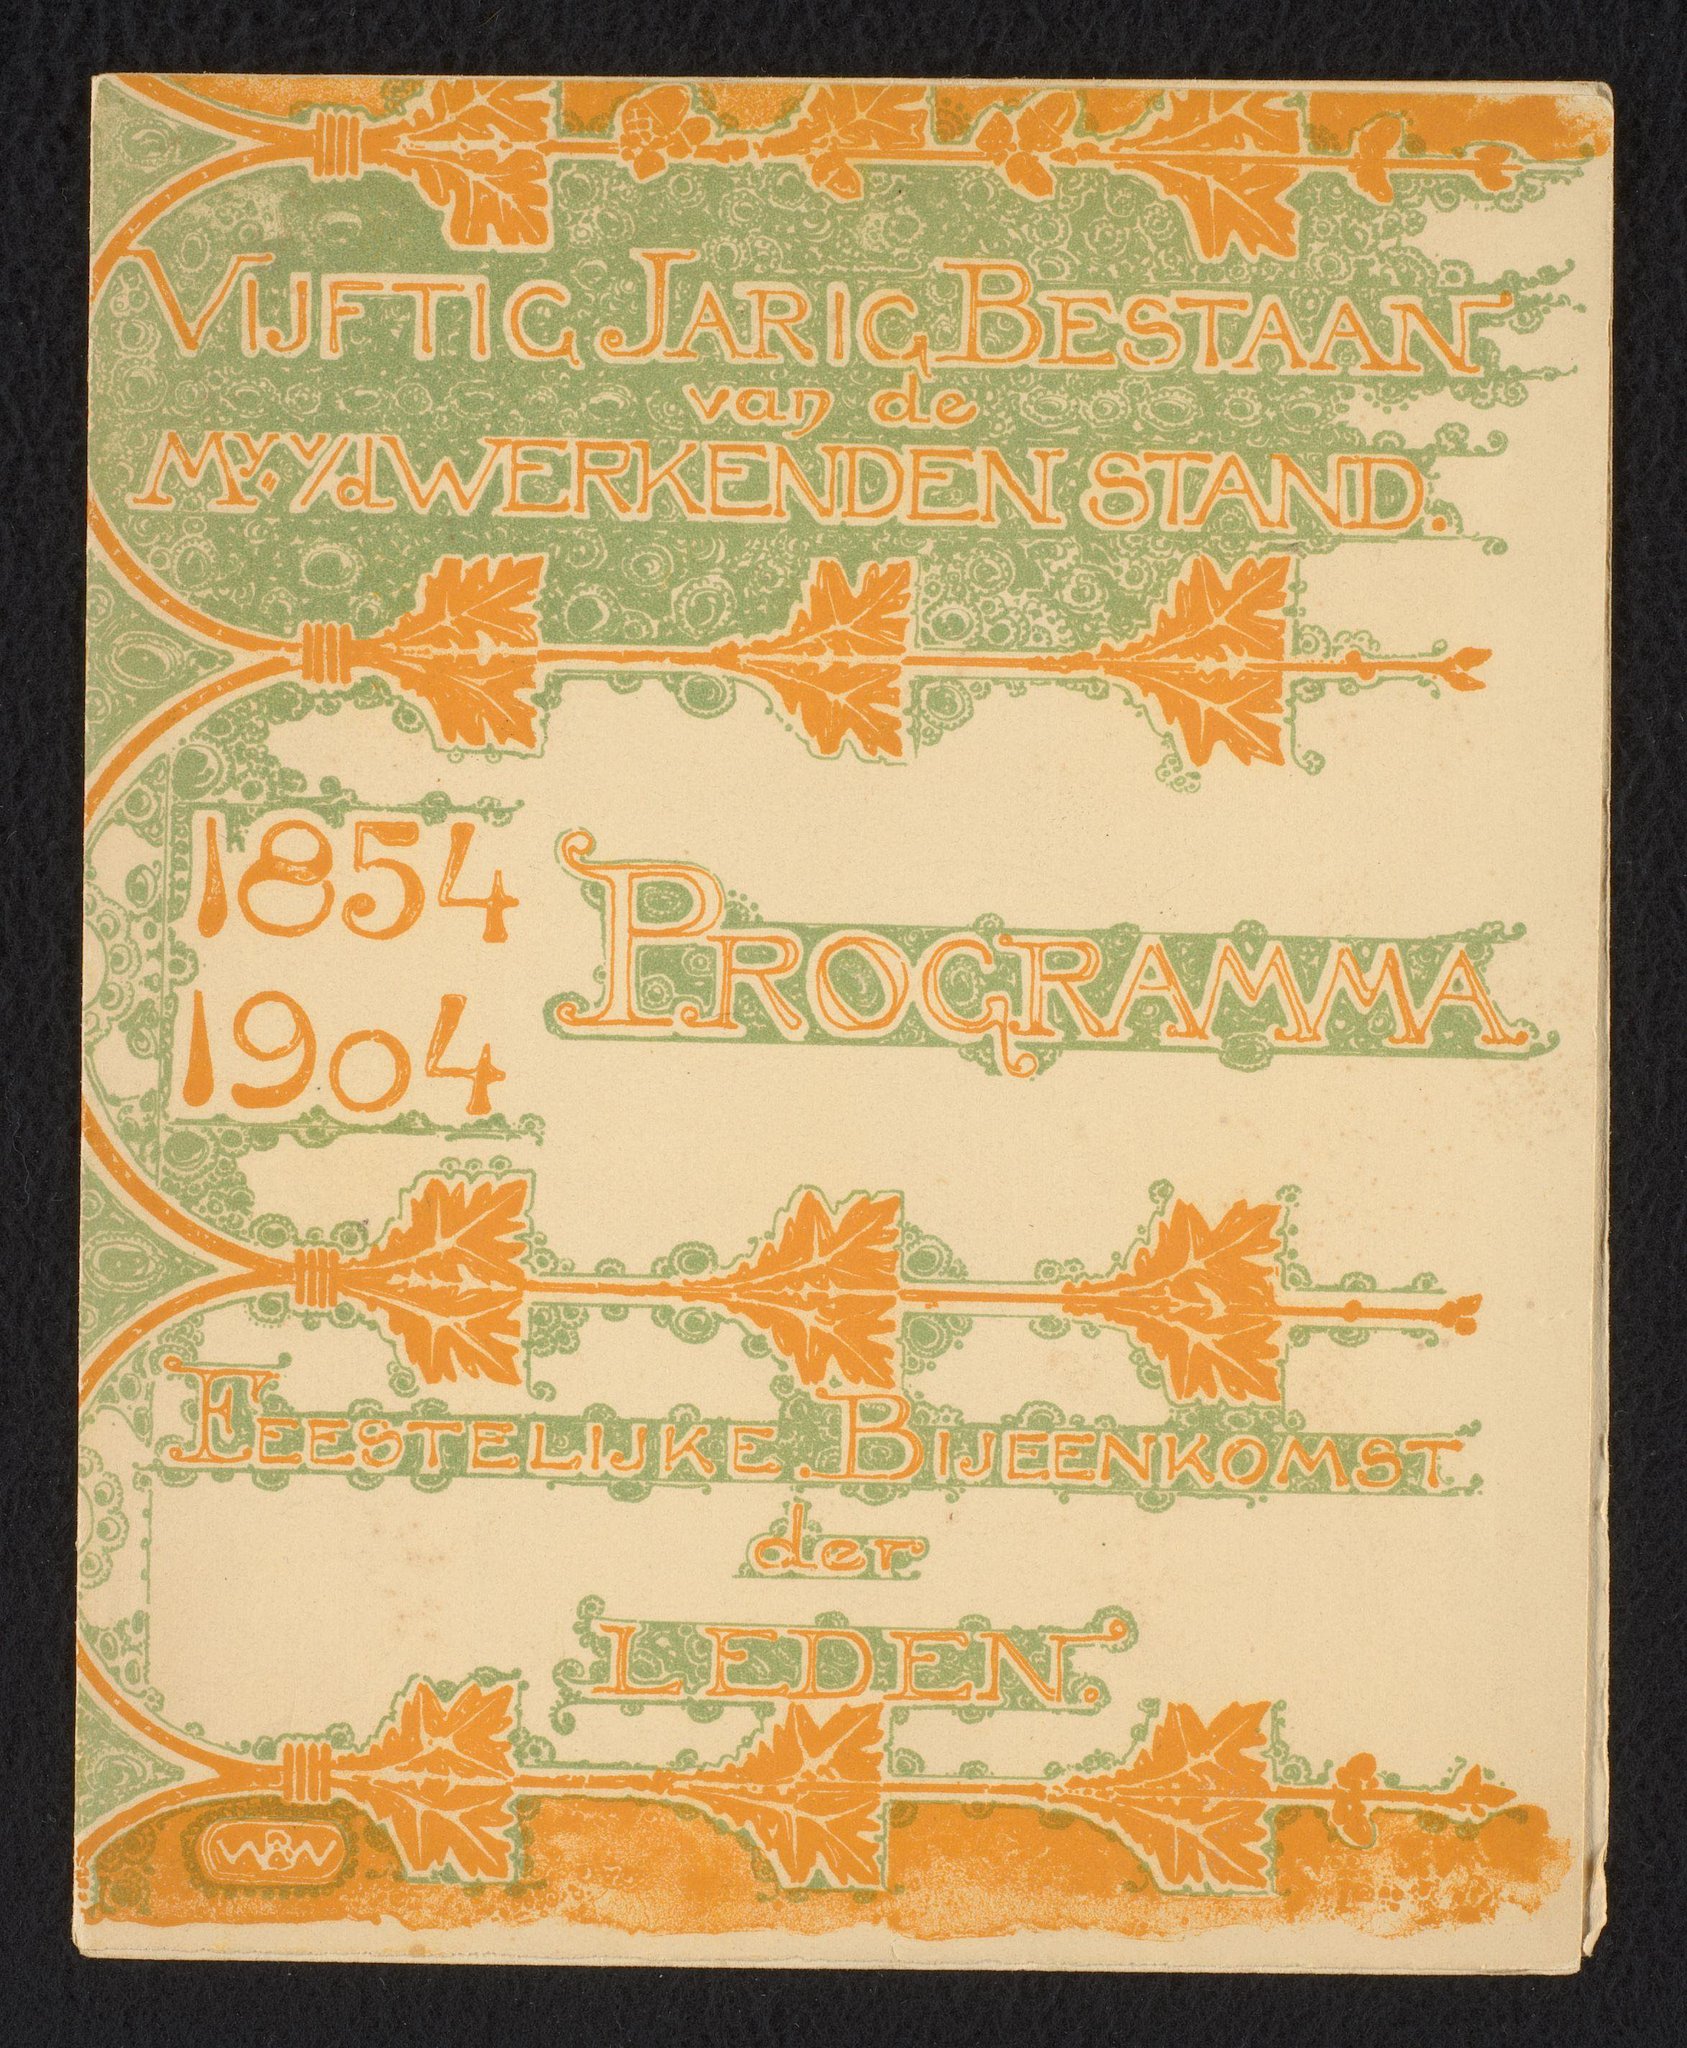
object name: programma, programmaboekje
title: Programma voor de 'Feestelijke Bijeenkomst' ter gelegenheid van het vijftigjarig bestaan van de Maatschappij voor den Werkenden Stand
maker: bernard willem wierink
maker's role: draughtsman, print maker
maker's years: 1856-1939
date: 1904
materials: paper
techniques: letterpress printing, lithograph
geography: amsterdam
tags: ornament derived from plant forms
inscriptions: date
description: Decoratief omslag met florale elementen en de tekst: 'Vijftig Jarig Bestaan van de My v/d Werkenden Stand. 1854 1904 Programma Feestelijke Bijeenkomst der Leden'. Binnenin het programma en enkele liedteksten. De bijeenkomst vond plaats op 12 januari 1904 in het Maatschappelijk Gebouw.